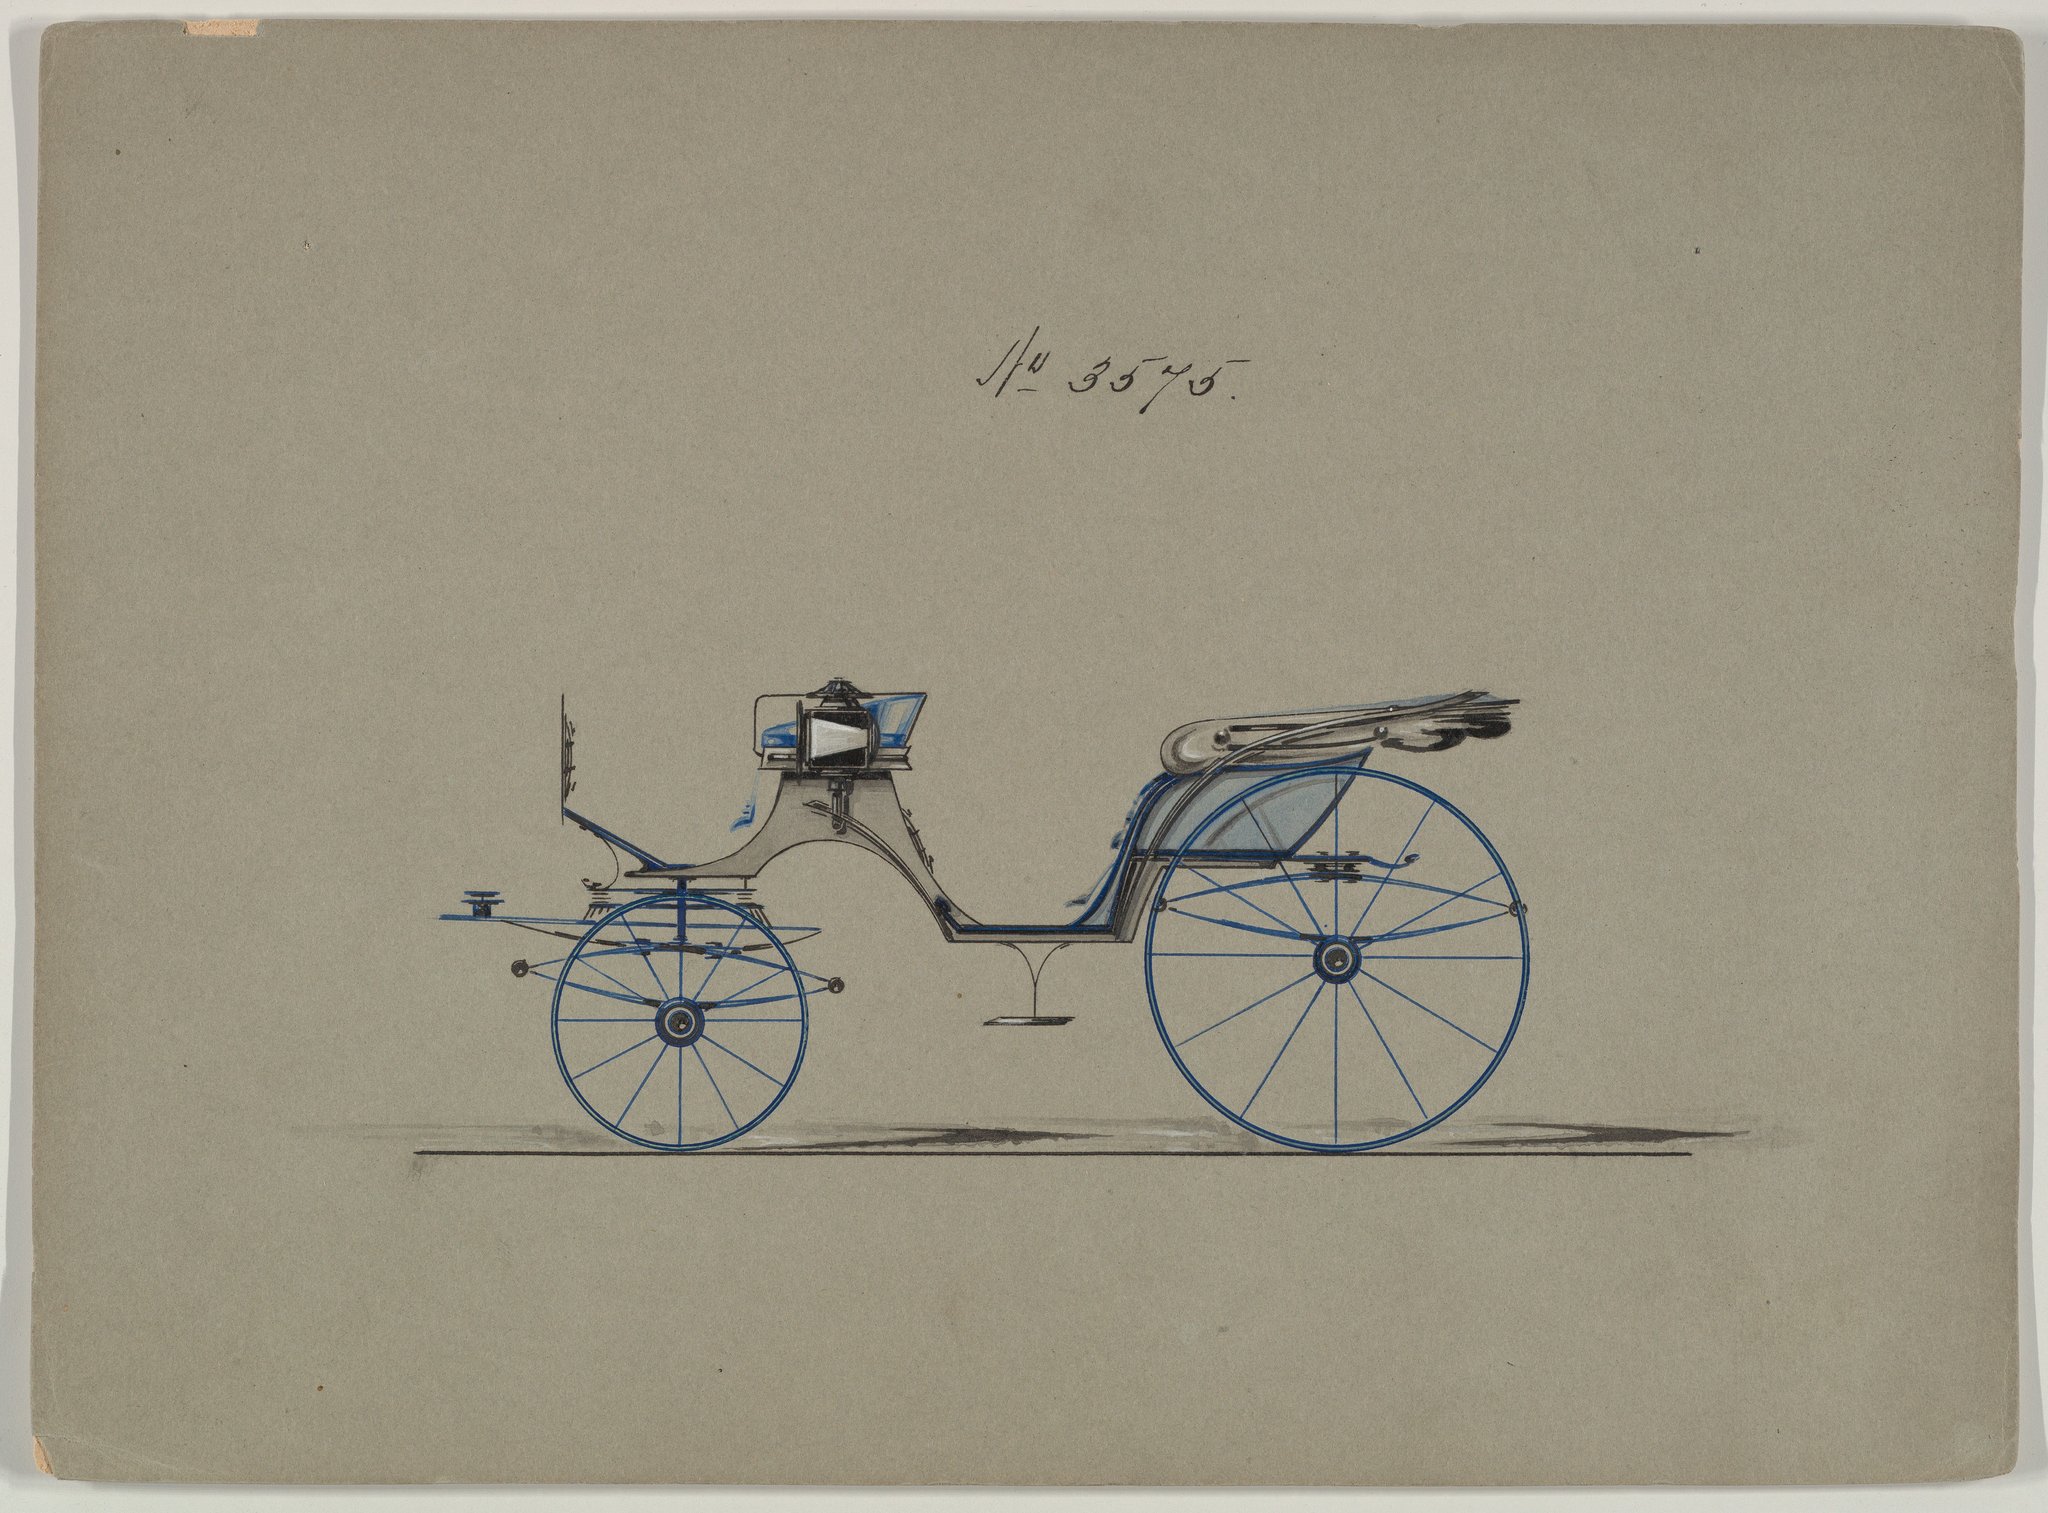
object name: drawing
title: Design for Cabriolet or Victoria, no. 3575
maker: brewster & co.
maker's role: manufacturer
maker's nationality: american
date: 1880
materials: gouache, ink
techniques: pen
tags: carriages